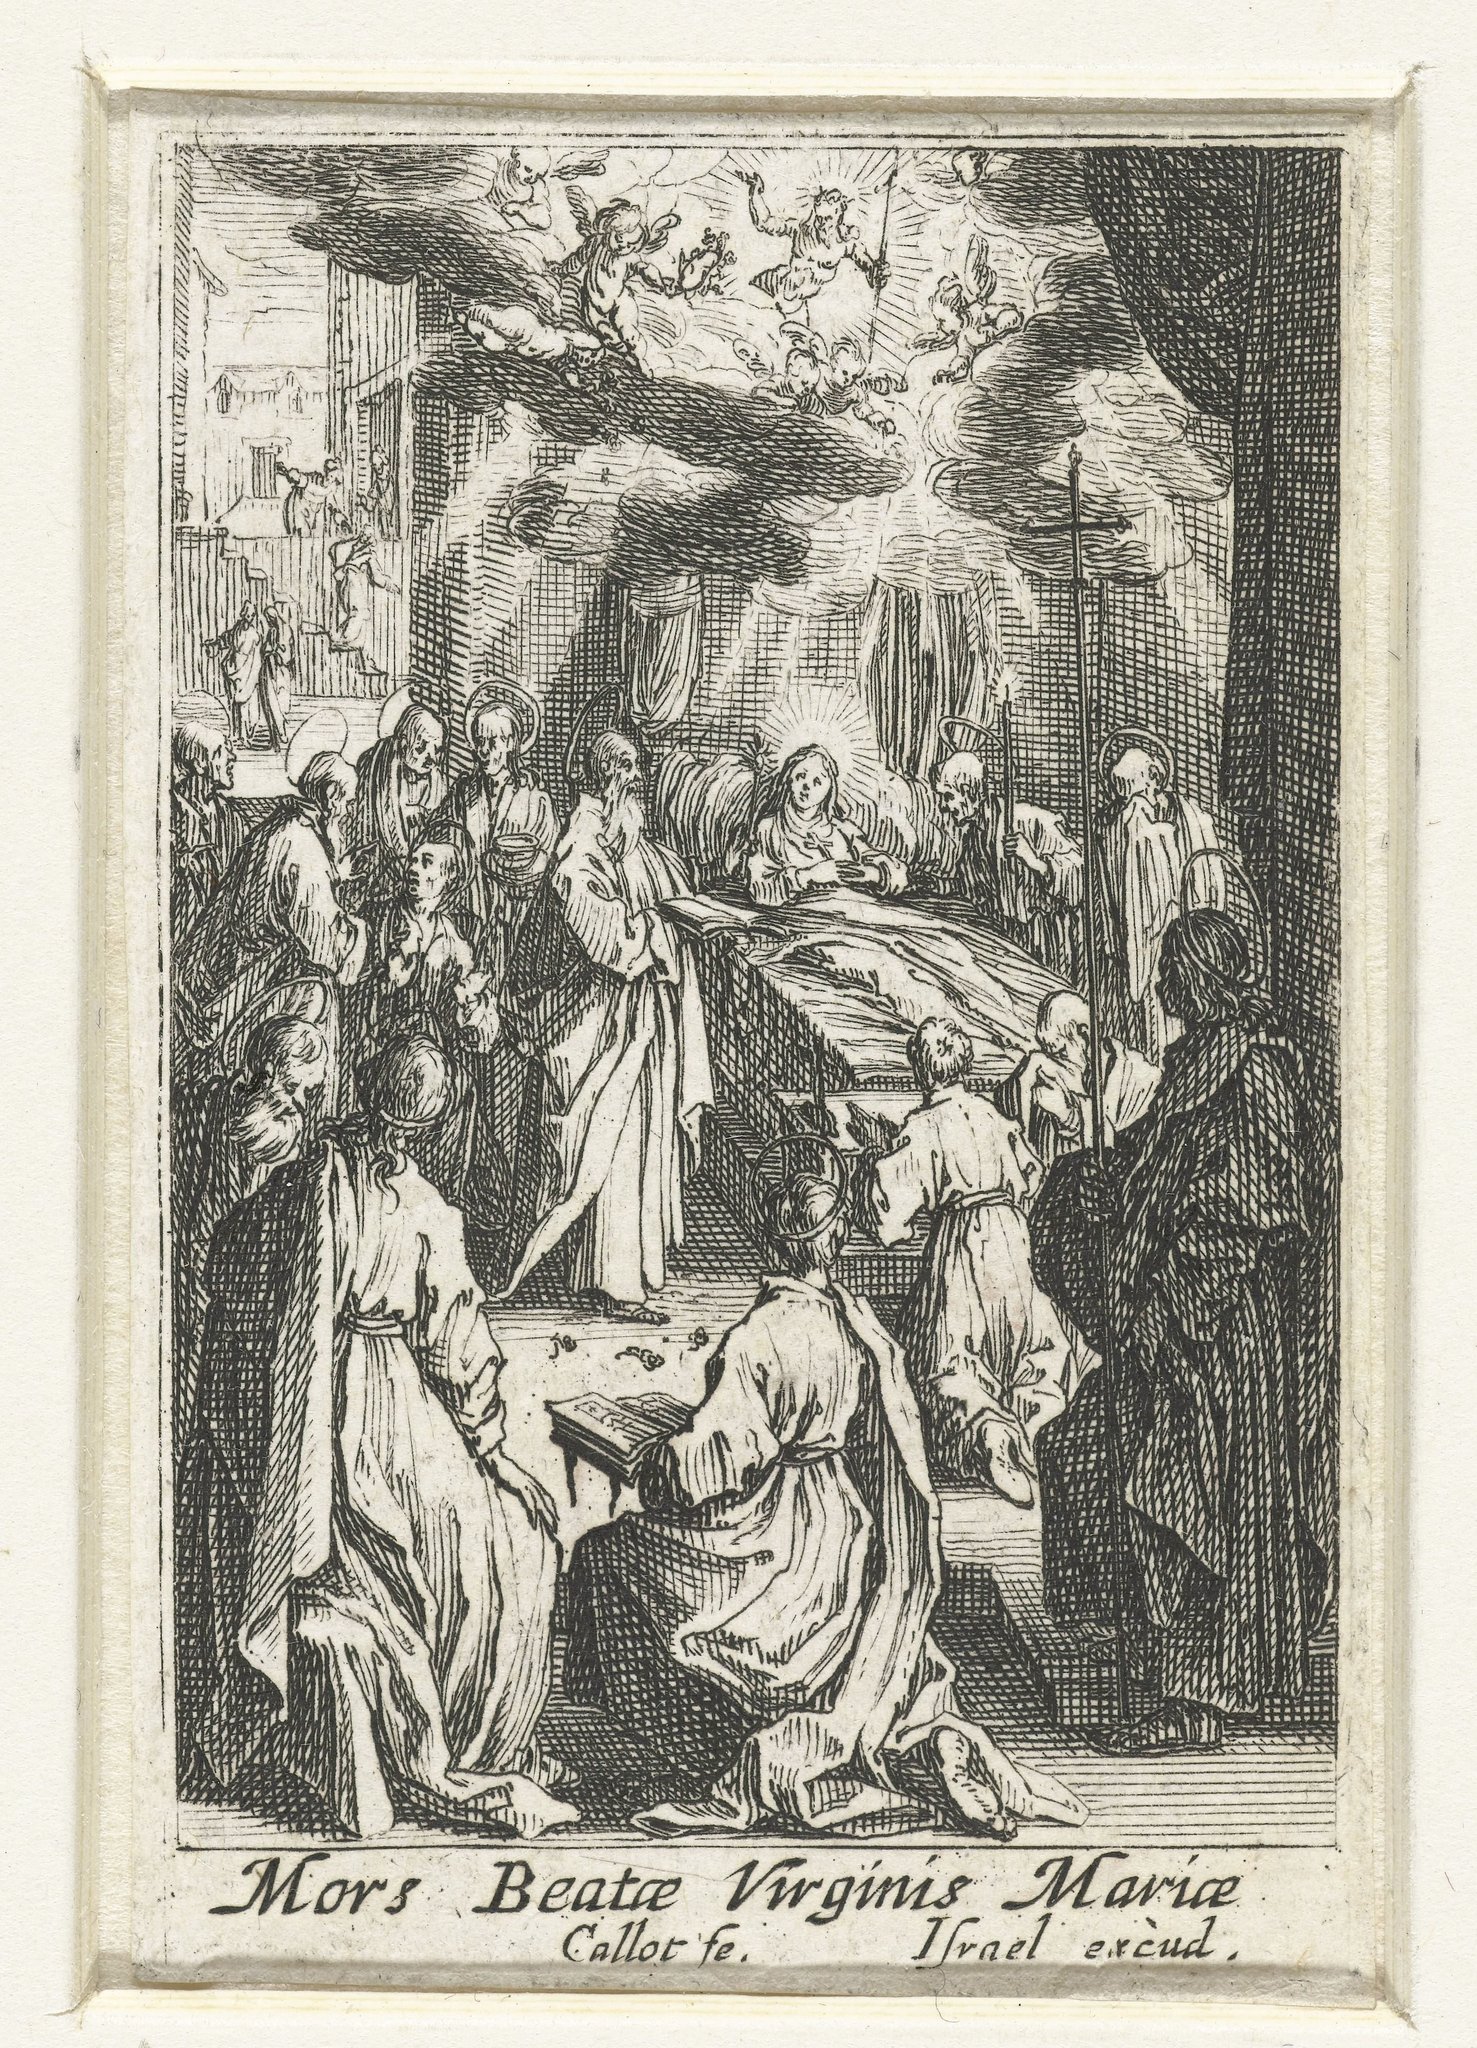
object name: print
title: Sterfbed van Maria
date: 1633-1634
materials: paper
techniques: etching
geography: paris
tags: the dormition: mary on her deathbed; the apostles are gathered around her (john the evangelist may be shown sleeping or dreaming)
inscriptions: collector's mark: Lugt 240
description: Maria ligt in een bed, omringd door de apostelen. Een van hen staat met een brandende kaars naast haar, een ander met een opengeslagen boek. Onder de voorstelling een onderschrift in Latijn. Deze prent is onderdeel van een reeks prenten rond het leven van Maria, bestaande uit een titelprent en dertien verhalende voorstellingen.